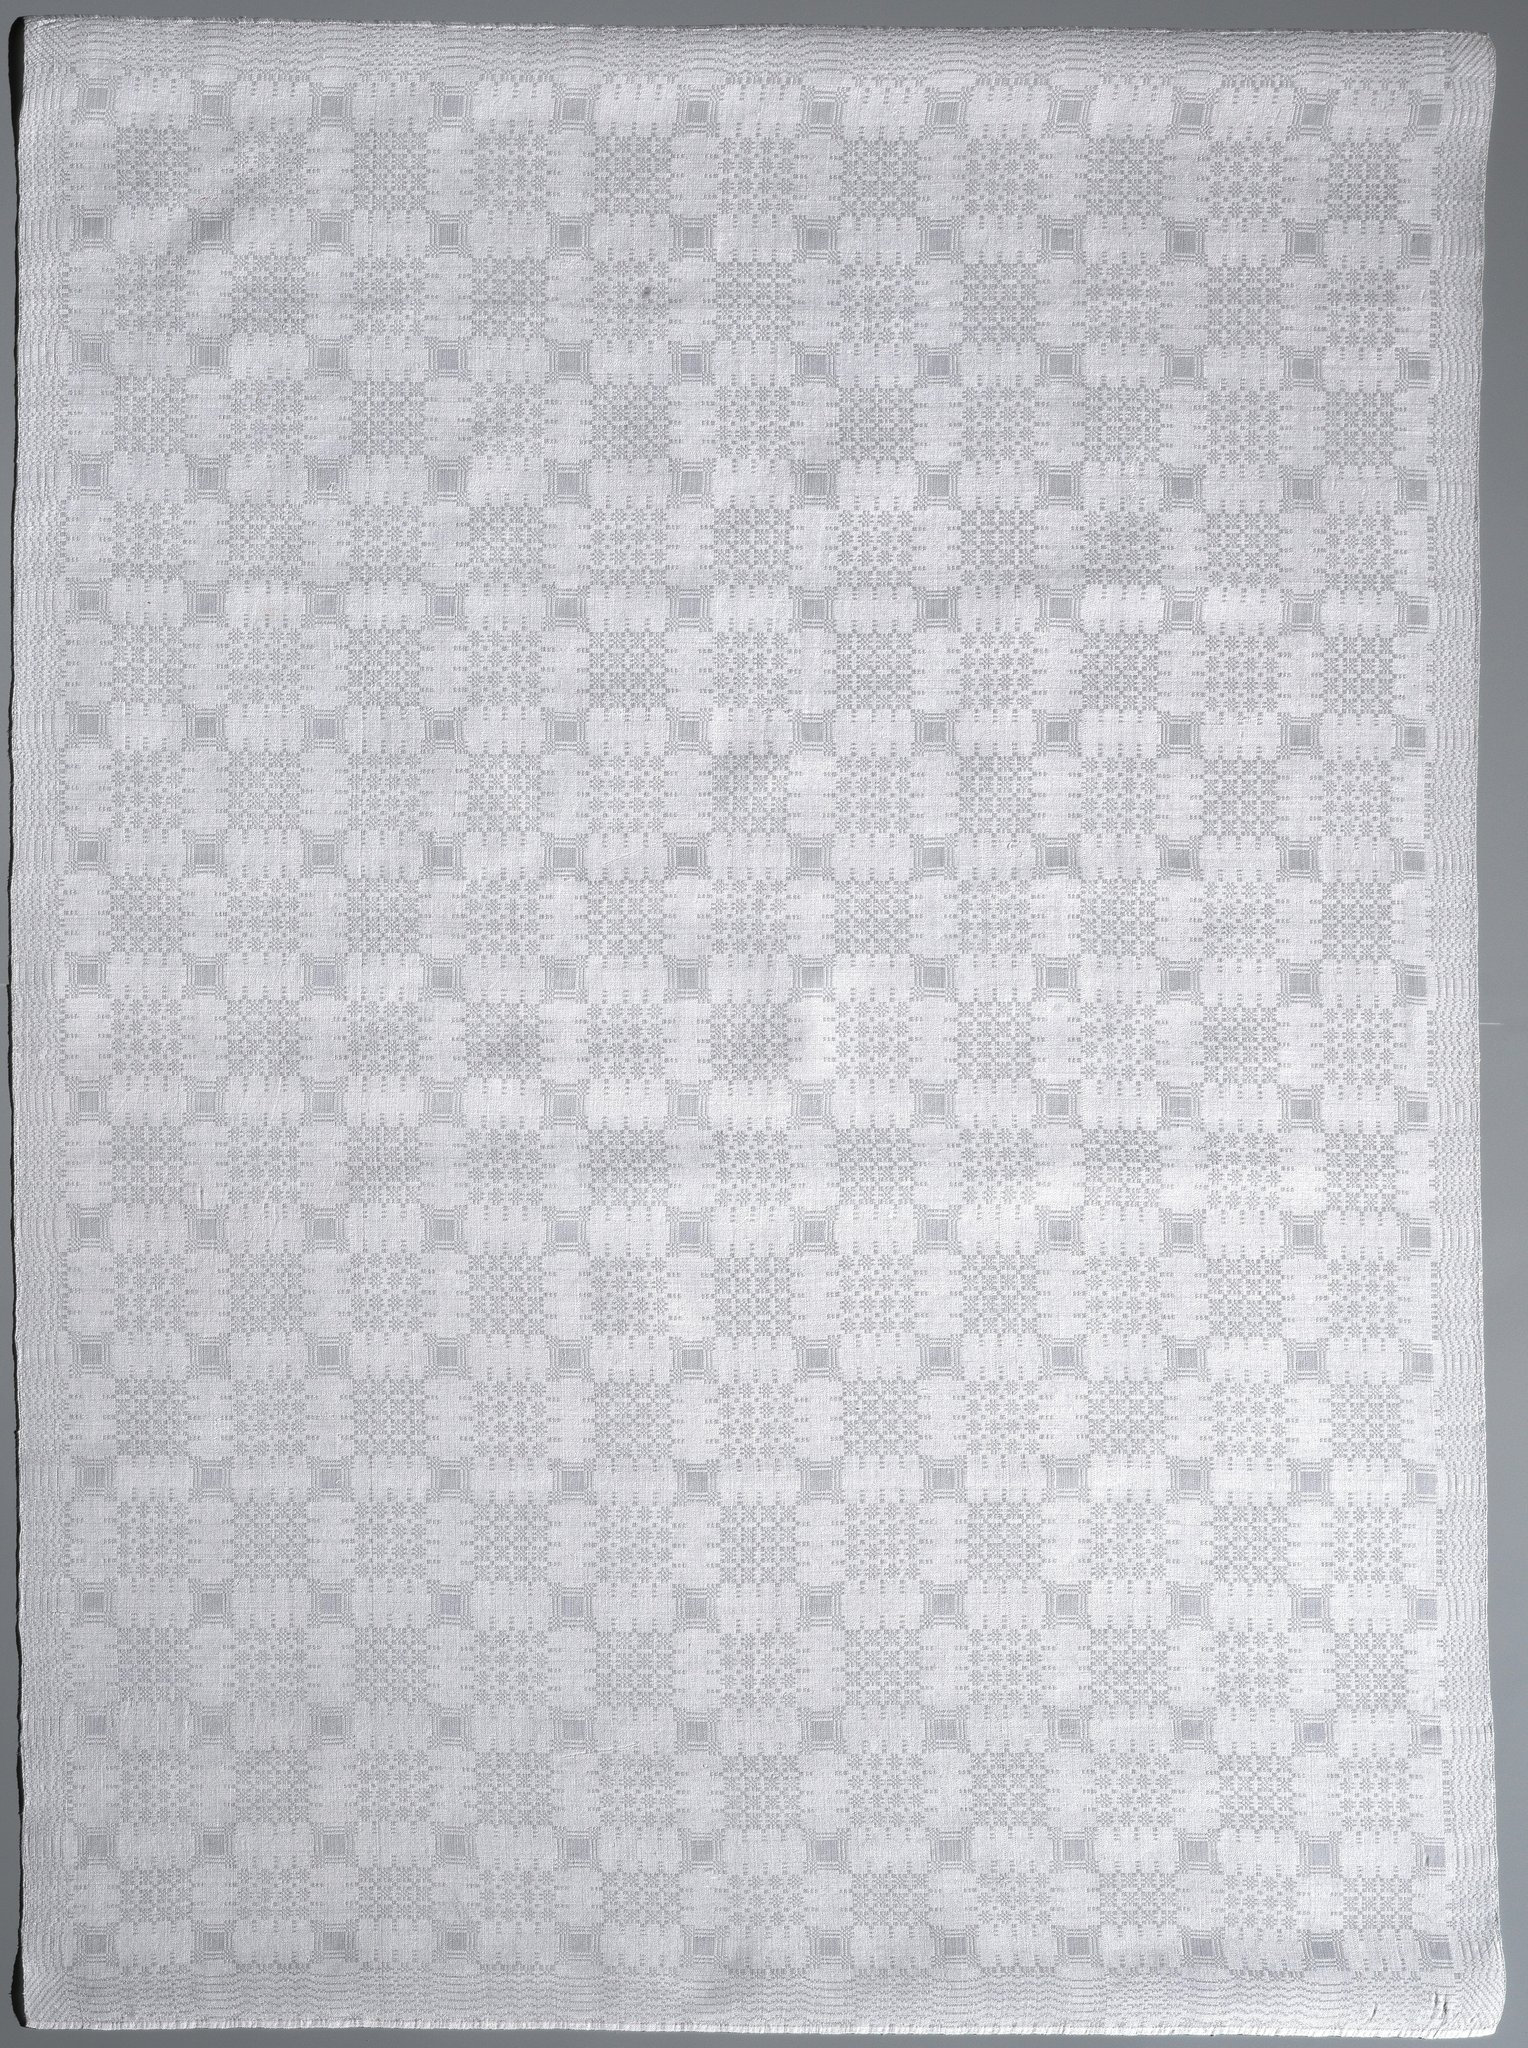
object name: napkin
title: Servet van linnen met pellenpatroon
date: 1700-1800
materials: linen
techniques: peeled fabric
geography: netherlands